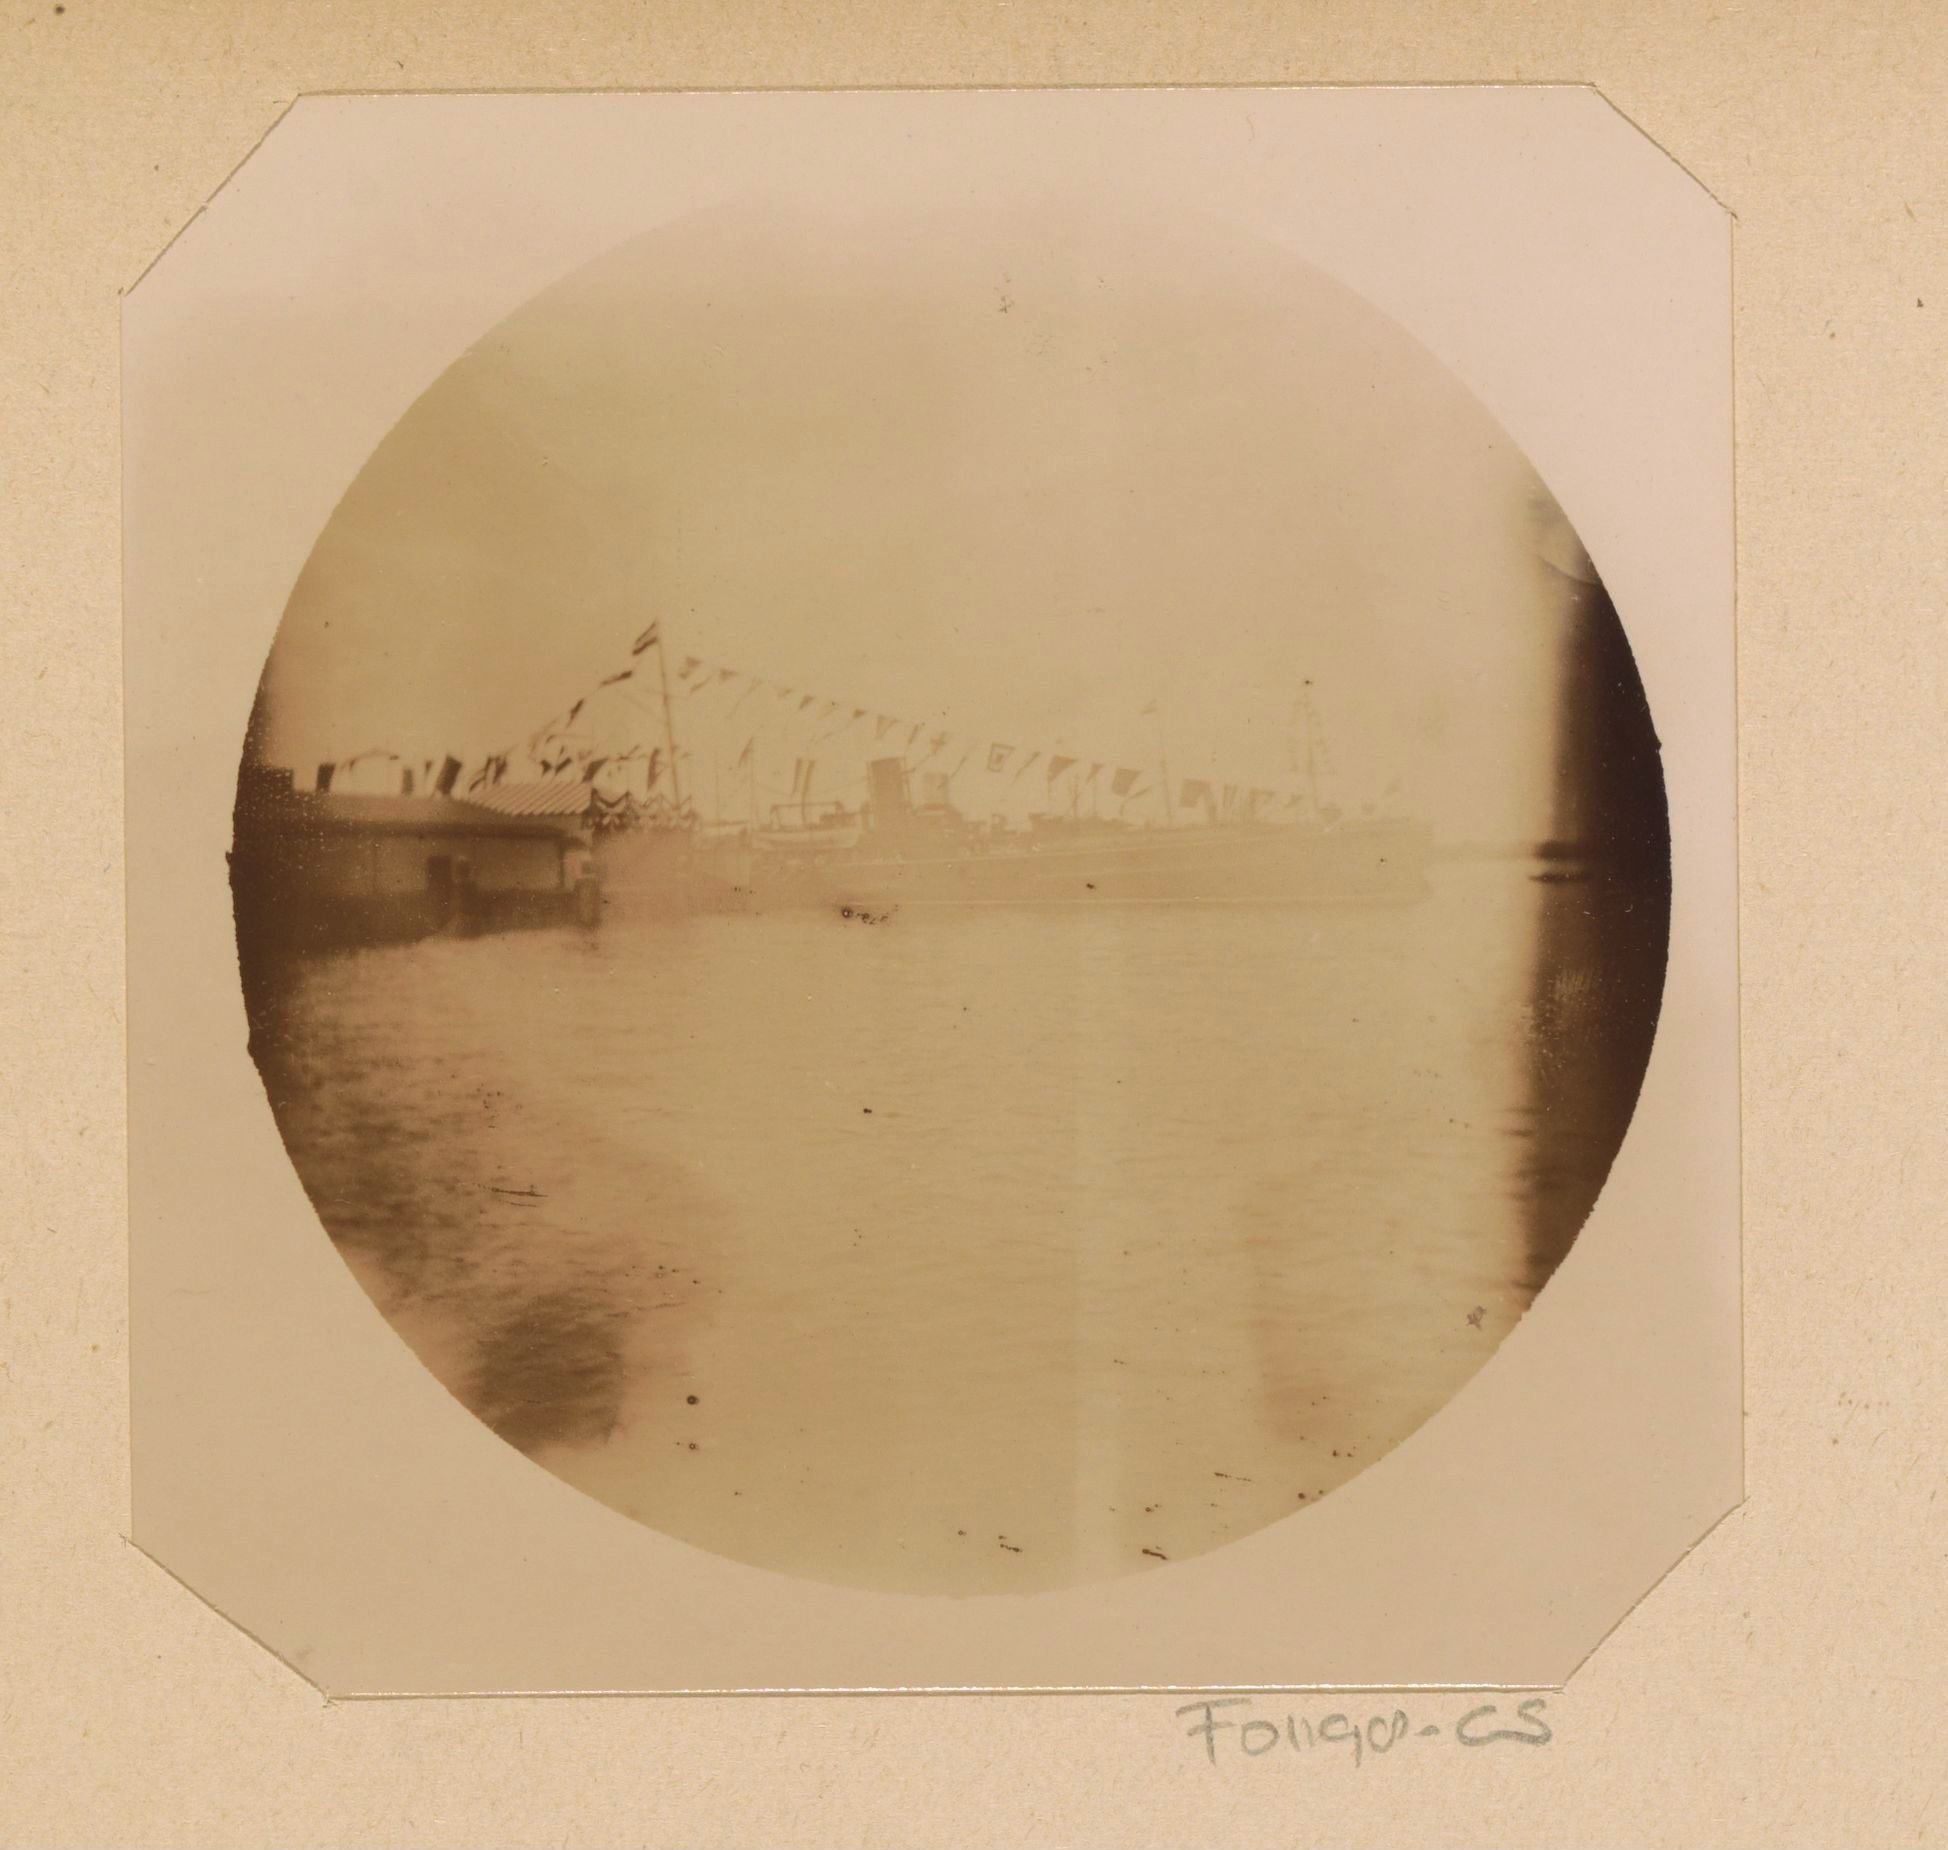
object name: album leaf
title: Keizersfeesten 1891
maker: johanna margaretha piek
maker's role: fotograaf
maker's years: 1870-1947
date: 1891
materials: paper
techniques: gelatin silver print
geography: amsterdam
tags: ships (in general), imperial celebrations 1891